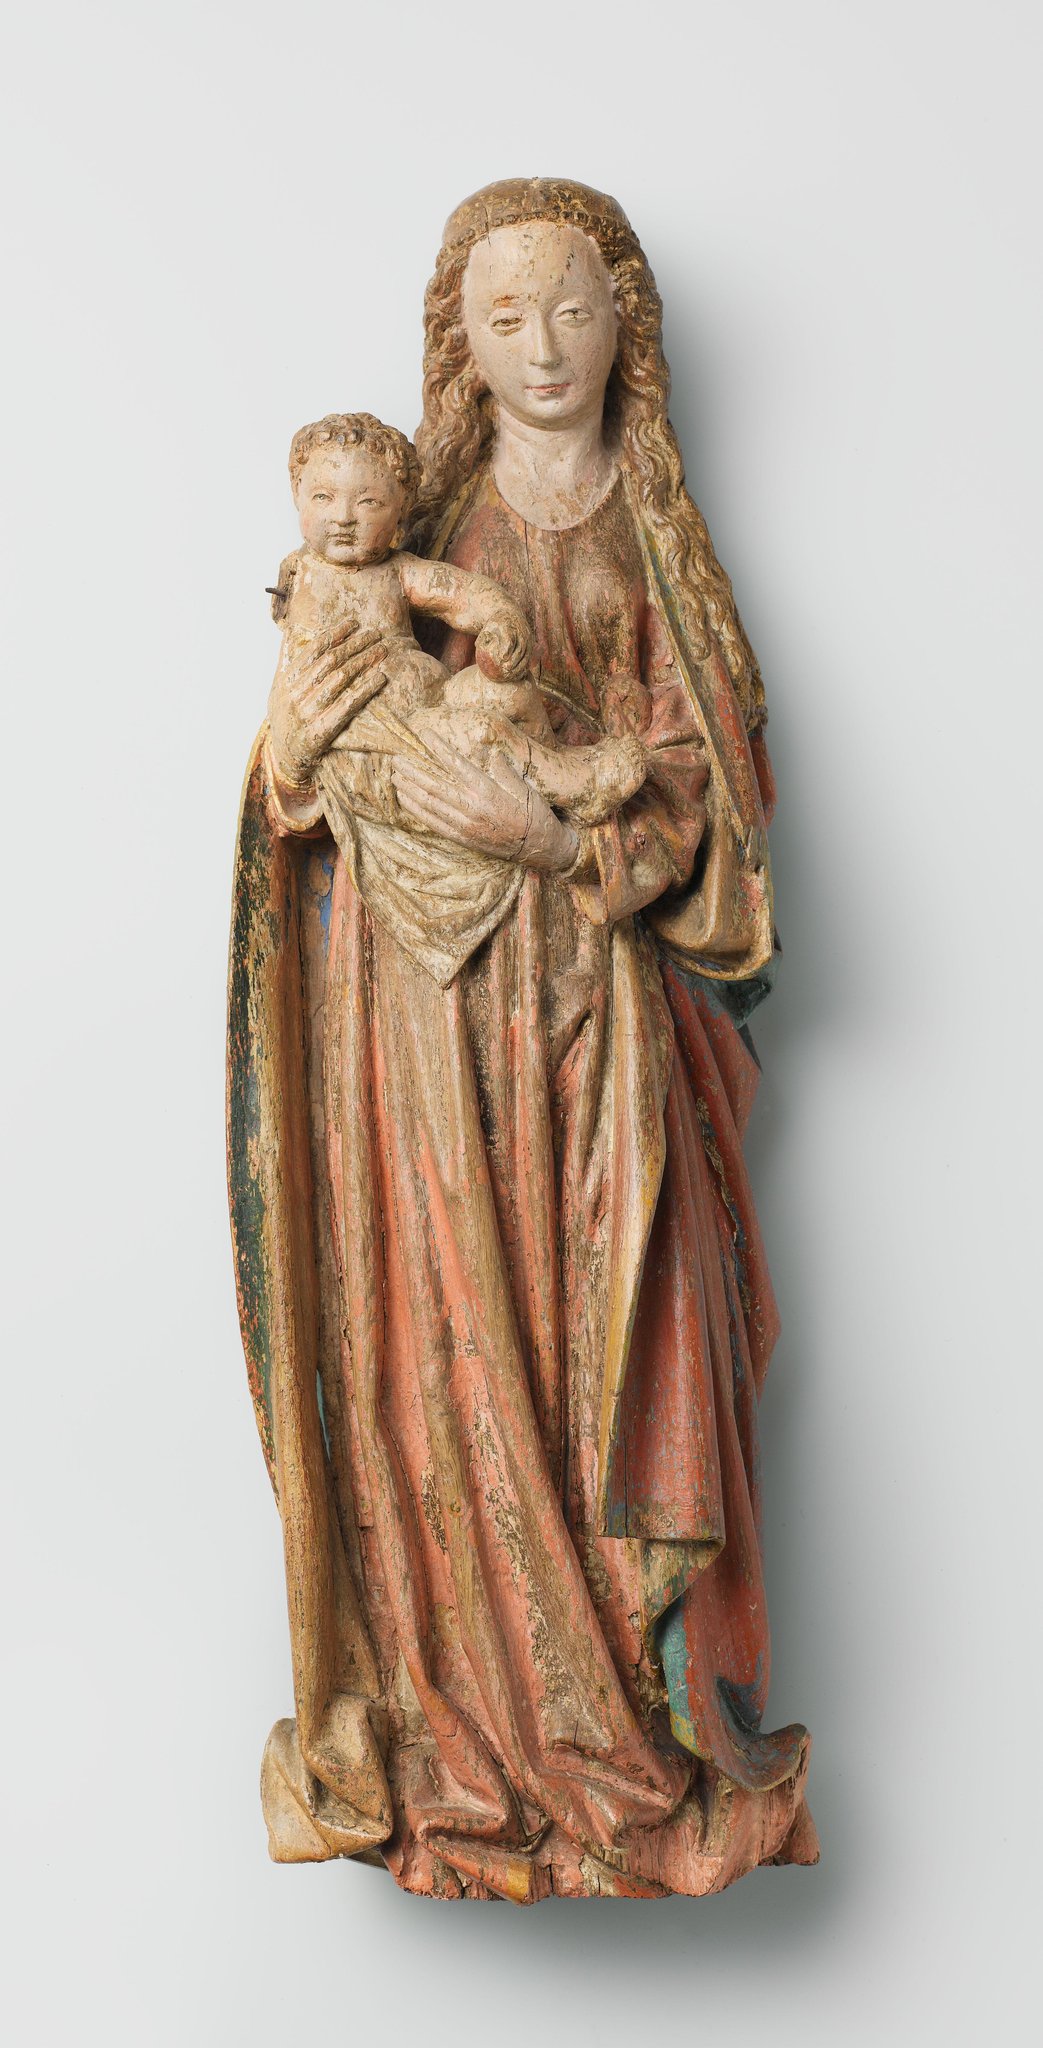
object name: sculpture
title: Virgin and Child, Standing on the Crescent Moon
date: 1490-1500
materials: wood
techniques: cutting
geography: brussels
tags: jezus christus, maria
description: In reliëf gesneden voorstelling van de staande Maria met Christuskind op de arm, staand op een maansikkel.